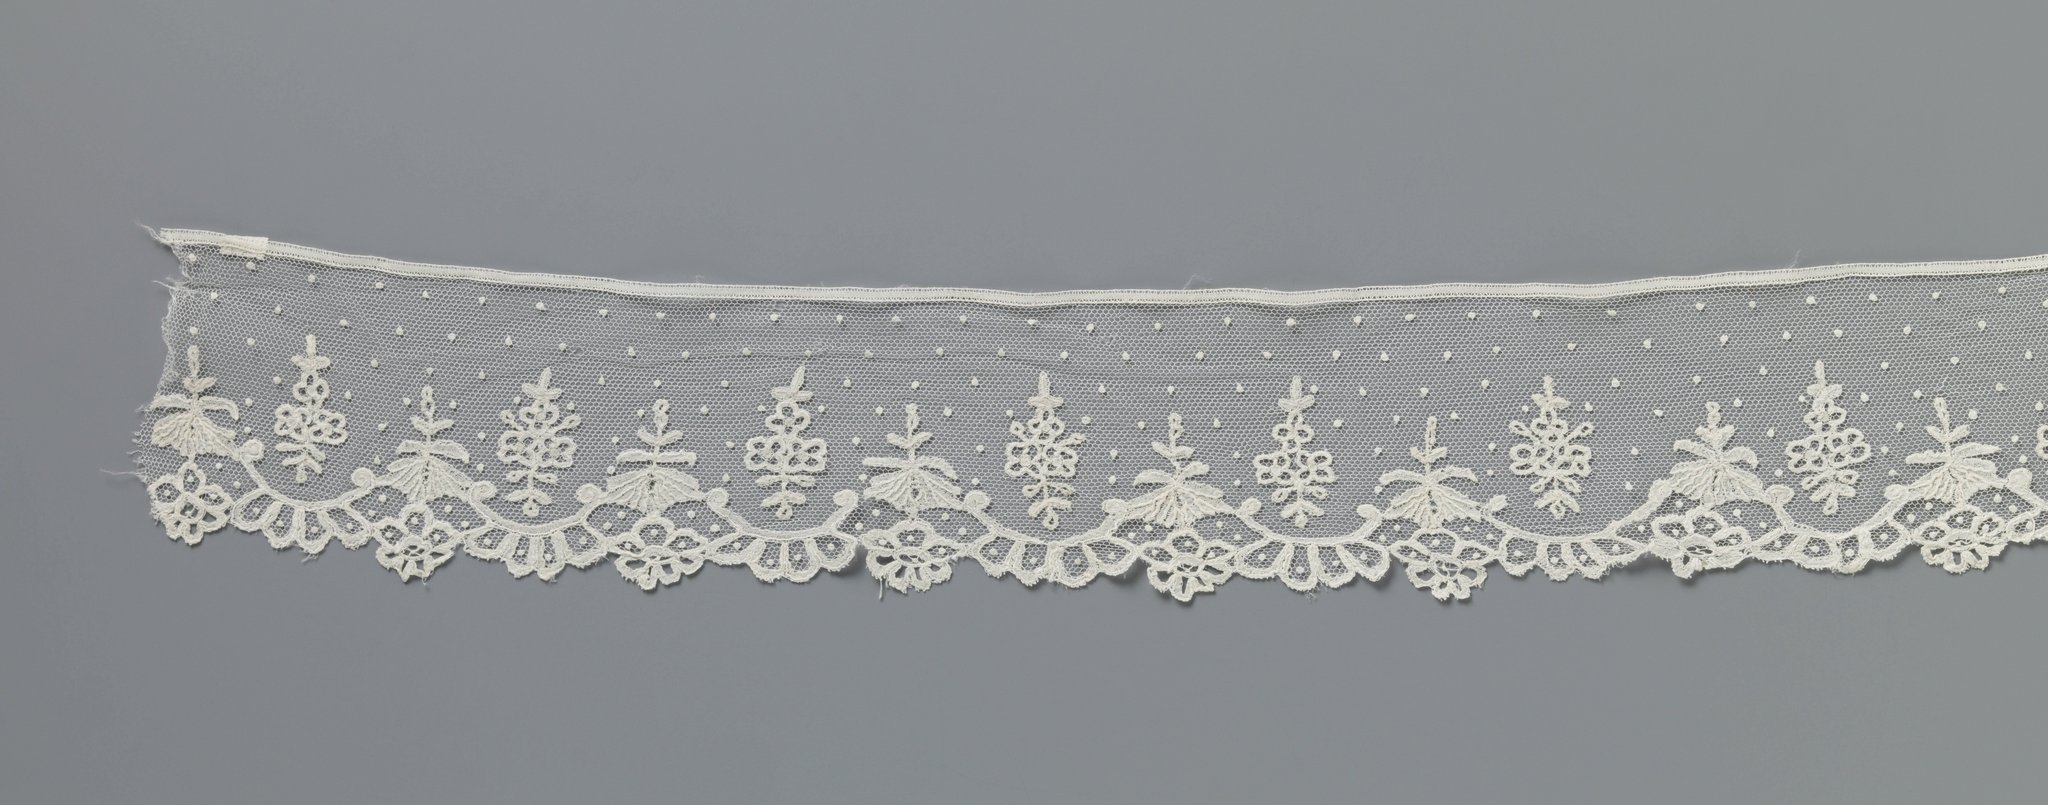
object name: strip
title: Strook applicatiekant met recht neerhangende bloemen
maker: Anonymous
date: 1900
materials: linen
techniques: lace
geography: brussels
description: Strook naturelkleurige applicatiekant, kloskant geappliceerd op machinale tule. Stijf symmetrisch dessin op een met moesejs bezaaid fond. Tussen schulpen met campanes worden de sluitstukken gevormd door hangende takjes, die met in grootte toenemende blaadjes en een rozetbloempje zijn versierd. Los boven de schulpen staat een recht takje, onder andere met drie bloemen.